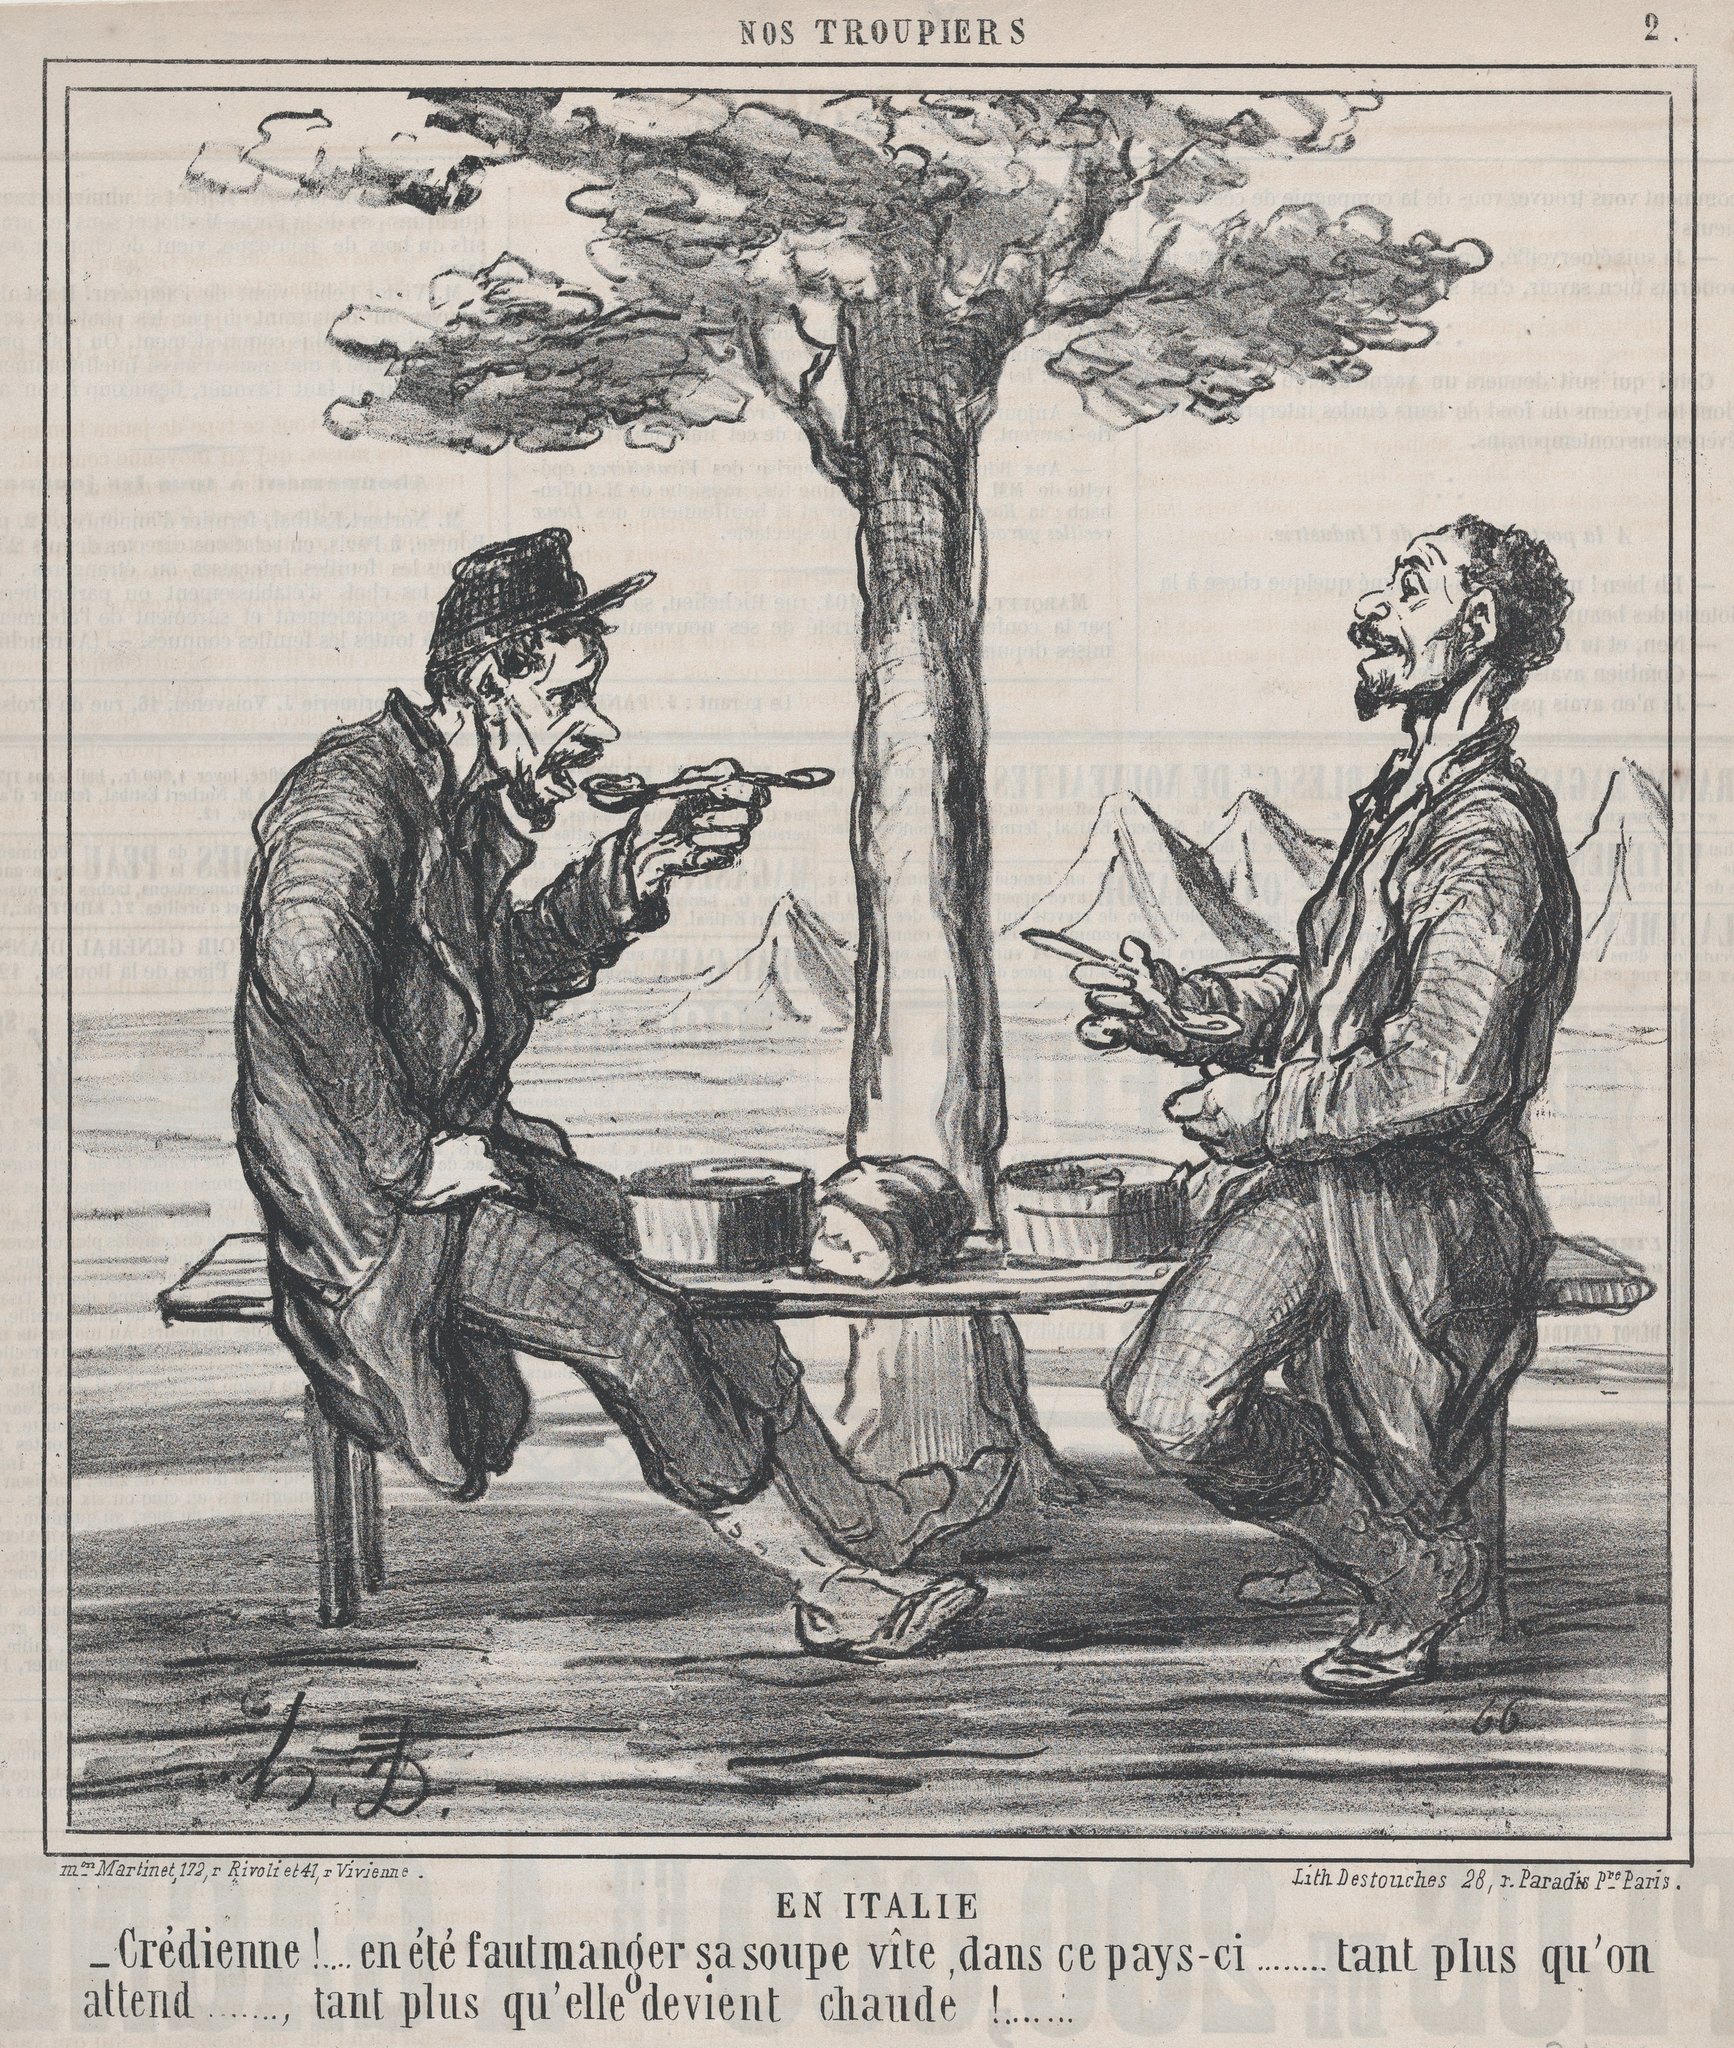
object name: print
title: En Italie, from "Nos Troupiers"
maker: honoré daumier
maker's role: artist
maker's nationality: french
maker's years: 1808-1879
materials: paper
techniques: lithograph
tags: men,trees